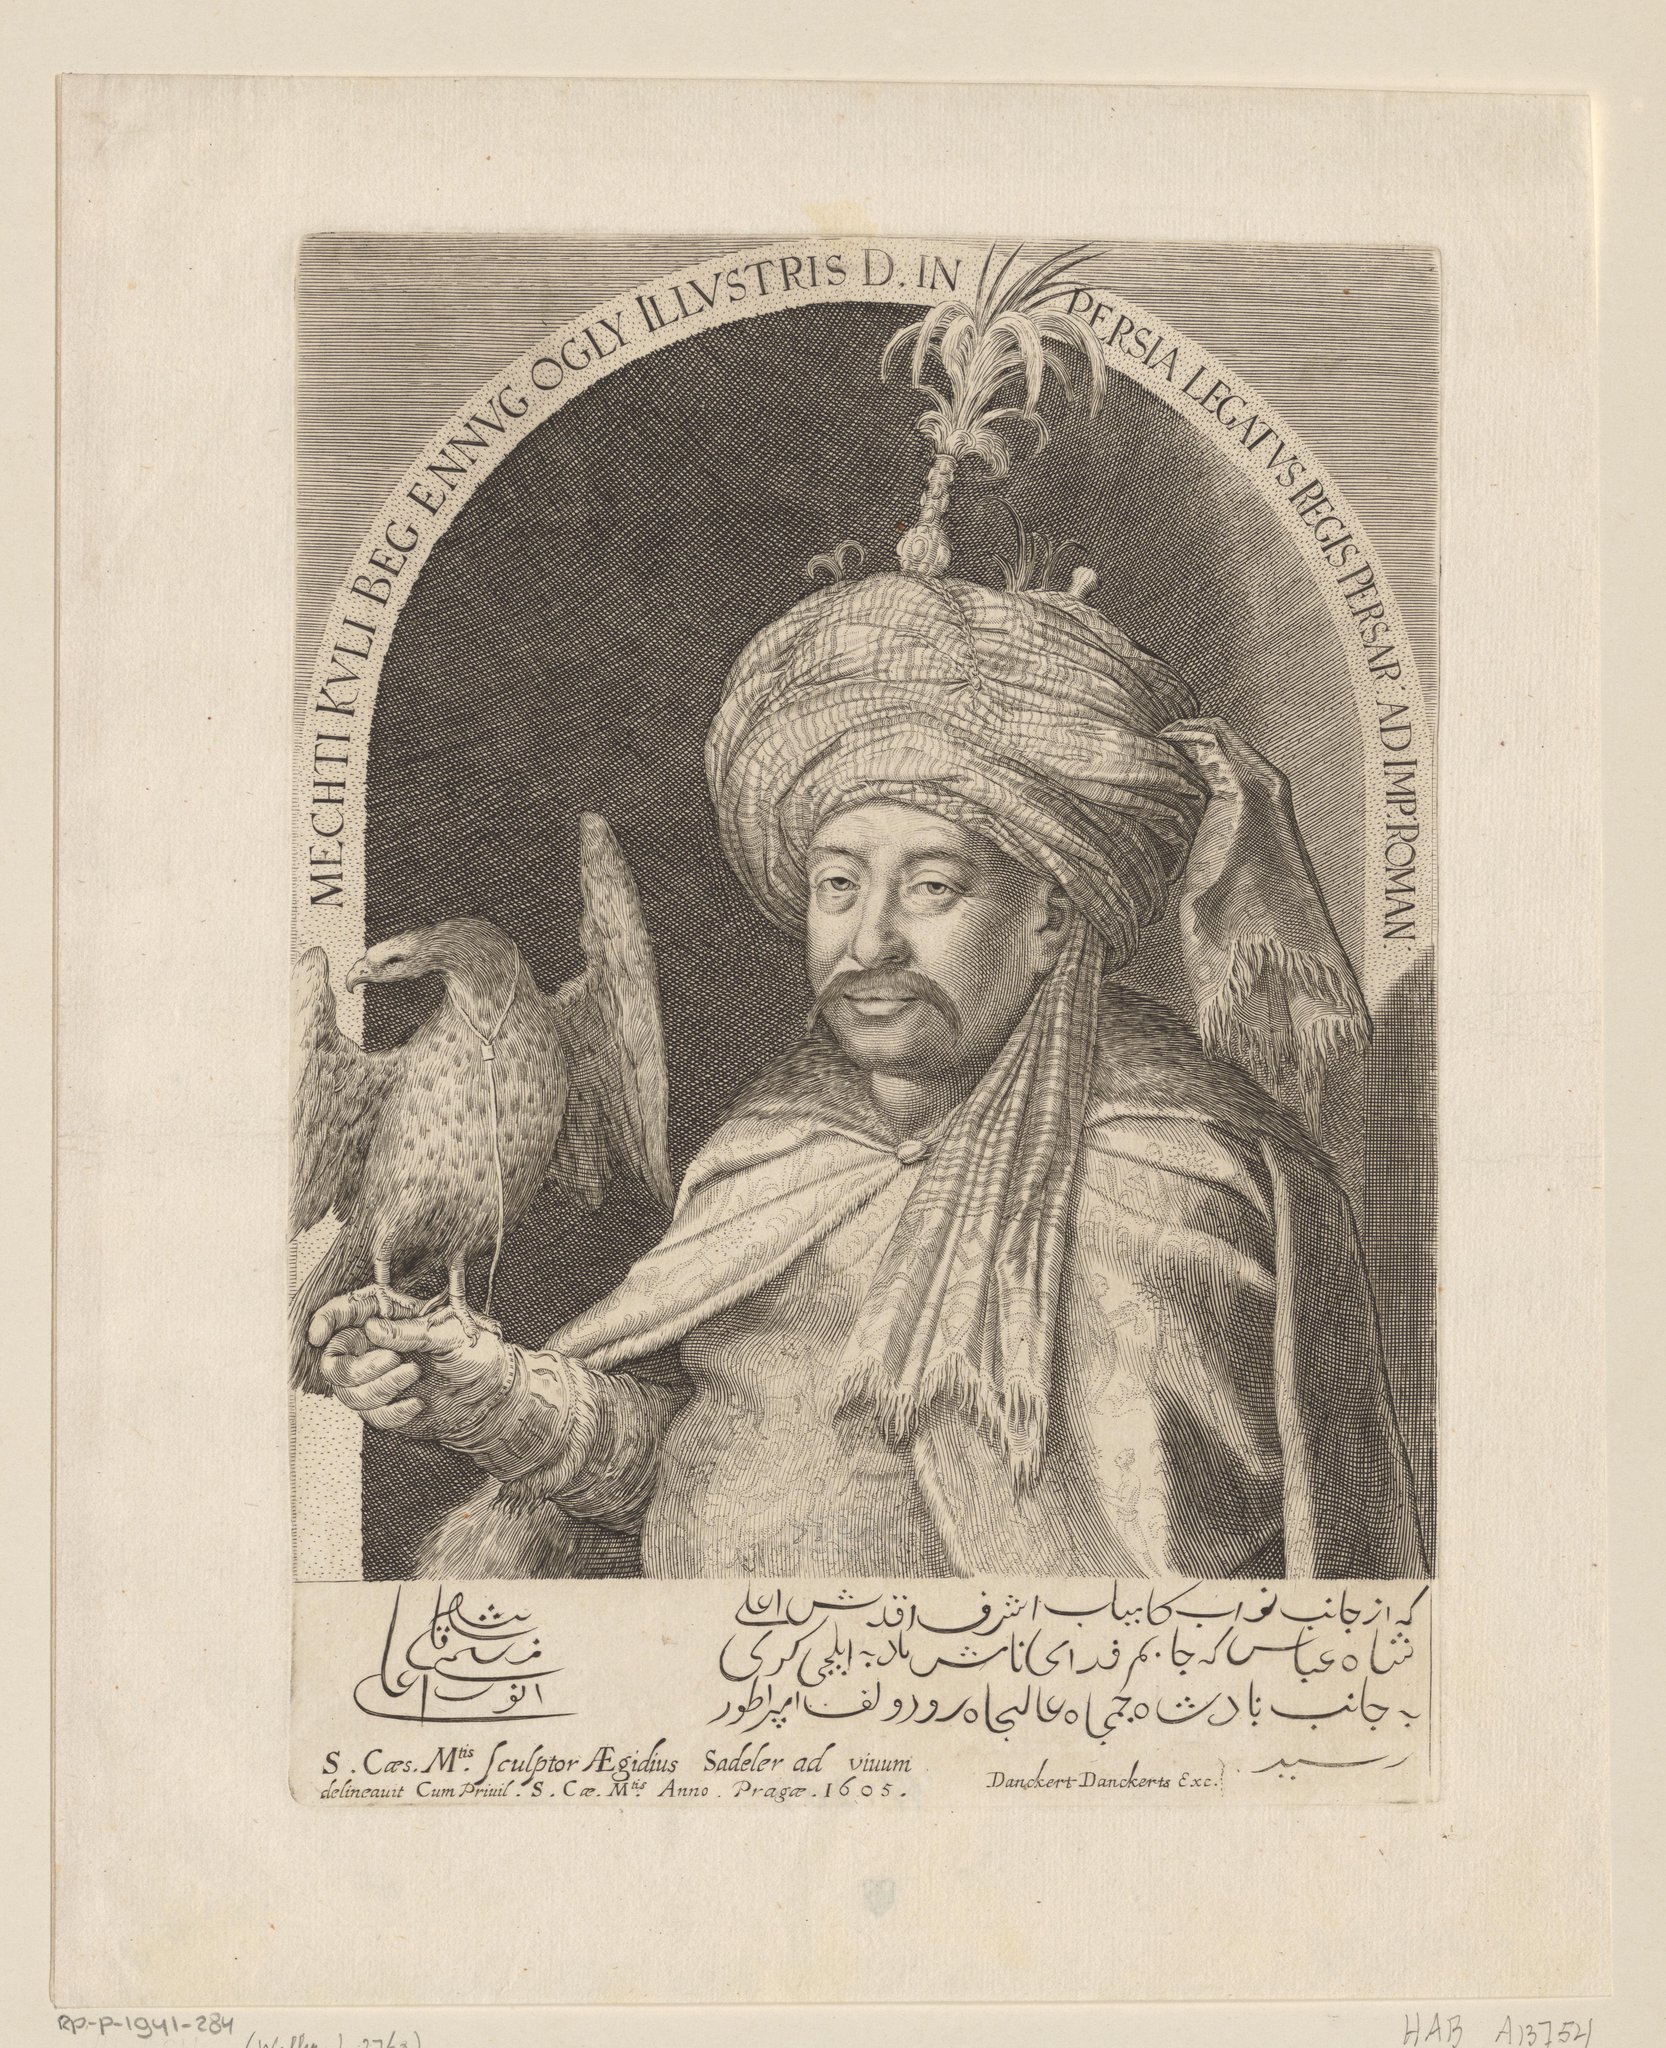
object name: print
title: Mecthi KuliBeg Ennug Ogly Illustris D. in Persia Legatus Regis Persar: ad Imp: Roman:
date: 1605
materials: paper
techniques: engraving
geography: prague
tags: predatory birds: eagle, historical persons, head-gear: turban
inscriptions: collector's mark: Lugt 2228, collector's mark: Lugt 2760